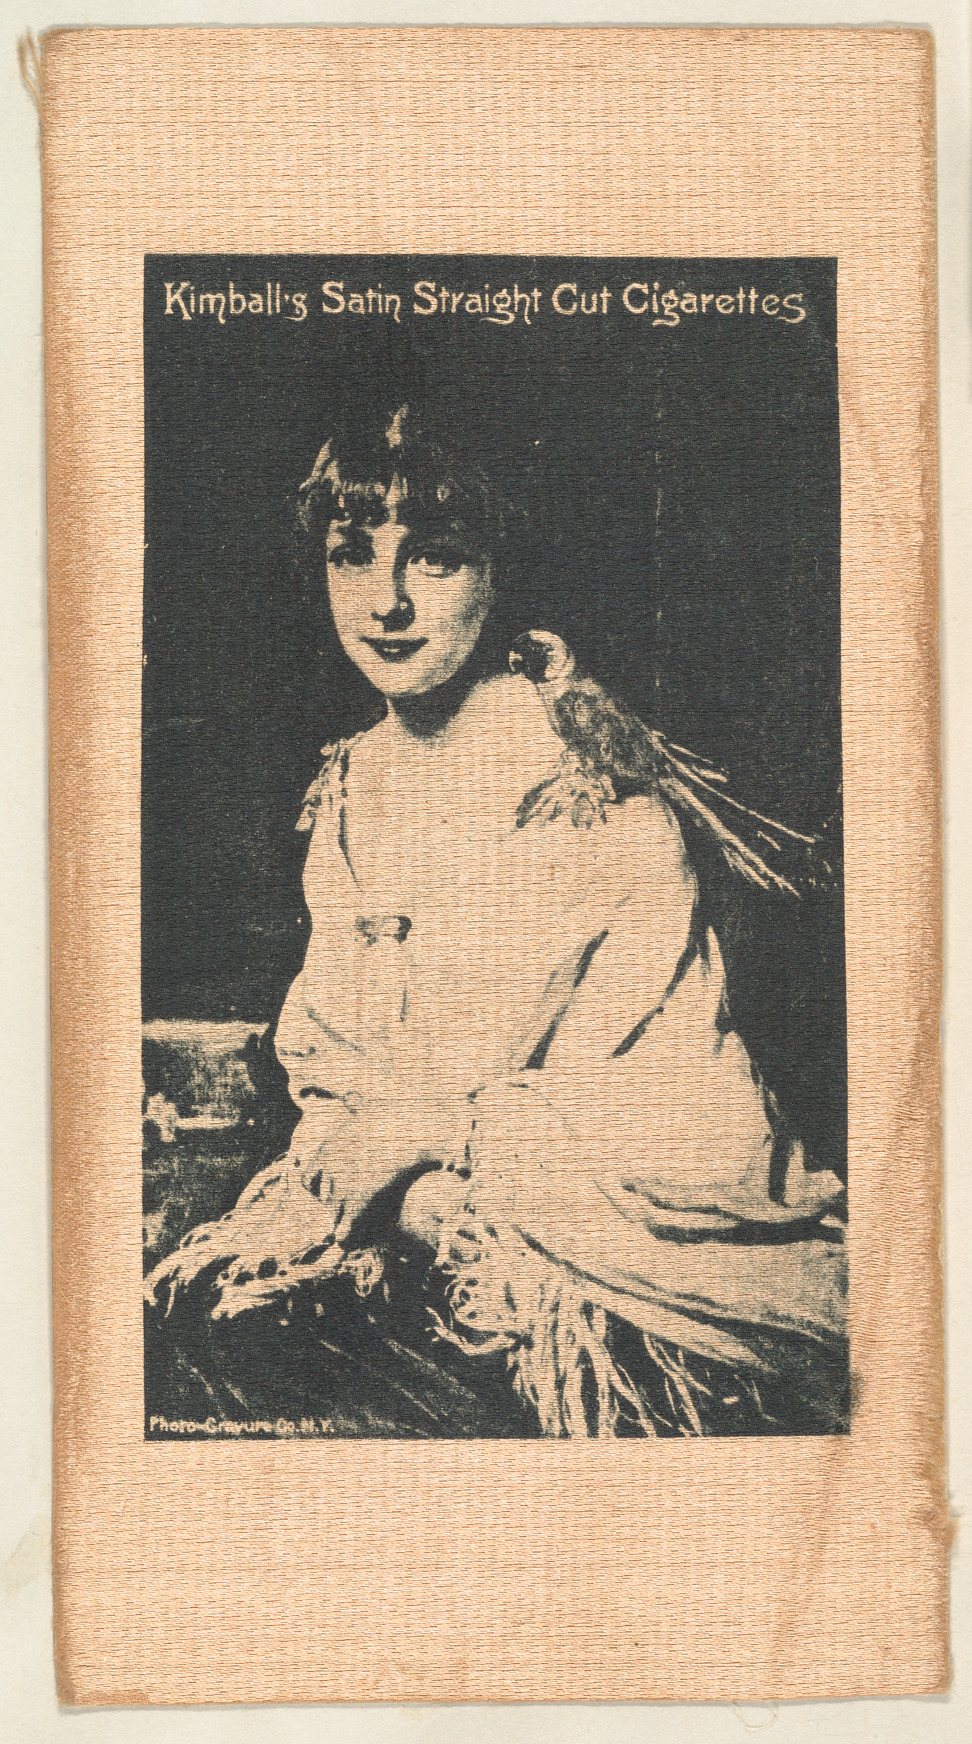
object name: print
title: Seated woman with bird on shoulder (on brown silk), from the Girl Art Subjects series (N193) issued by Wm. S. Kimball & Co.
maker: william s. kimball & company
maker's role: publisher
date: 1890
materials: silk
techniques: lithography, printing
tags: birds,women